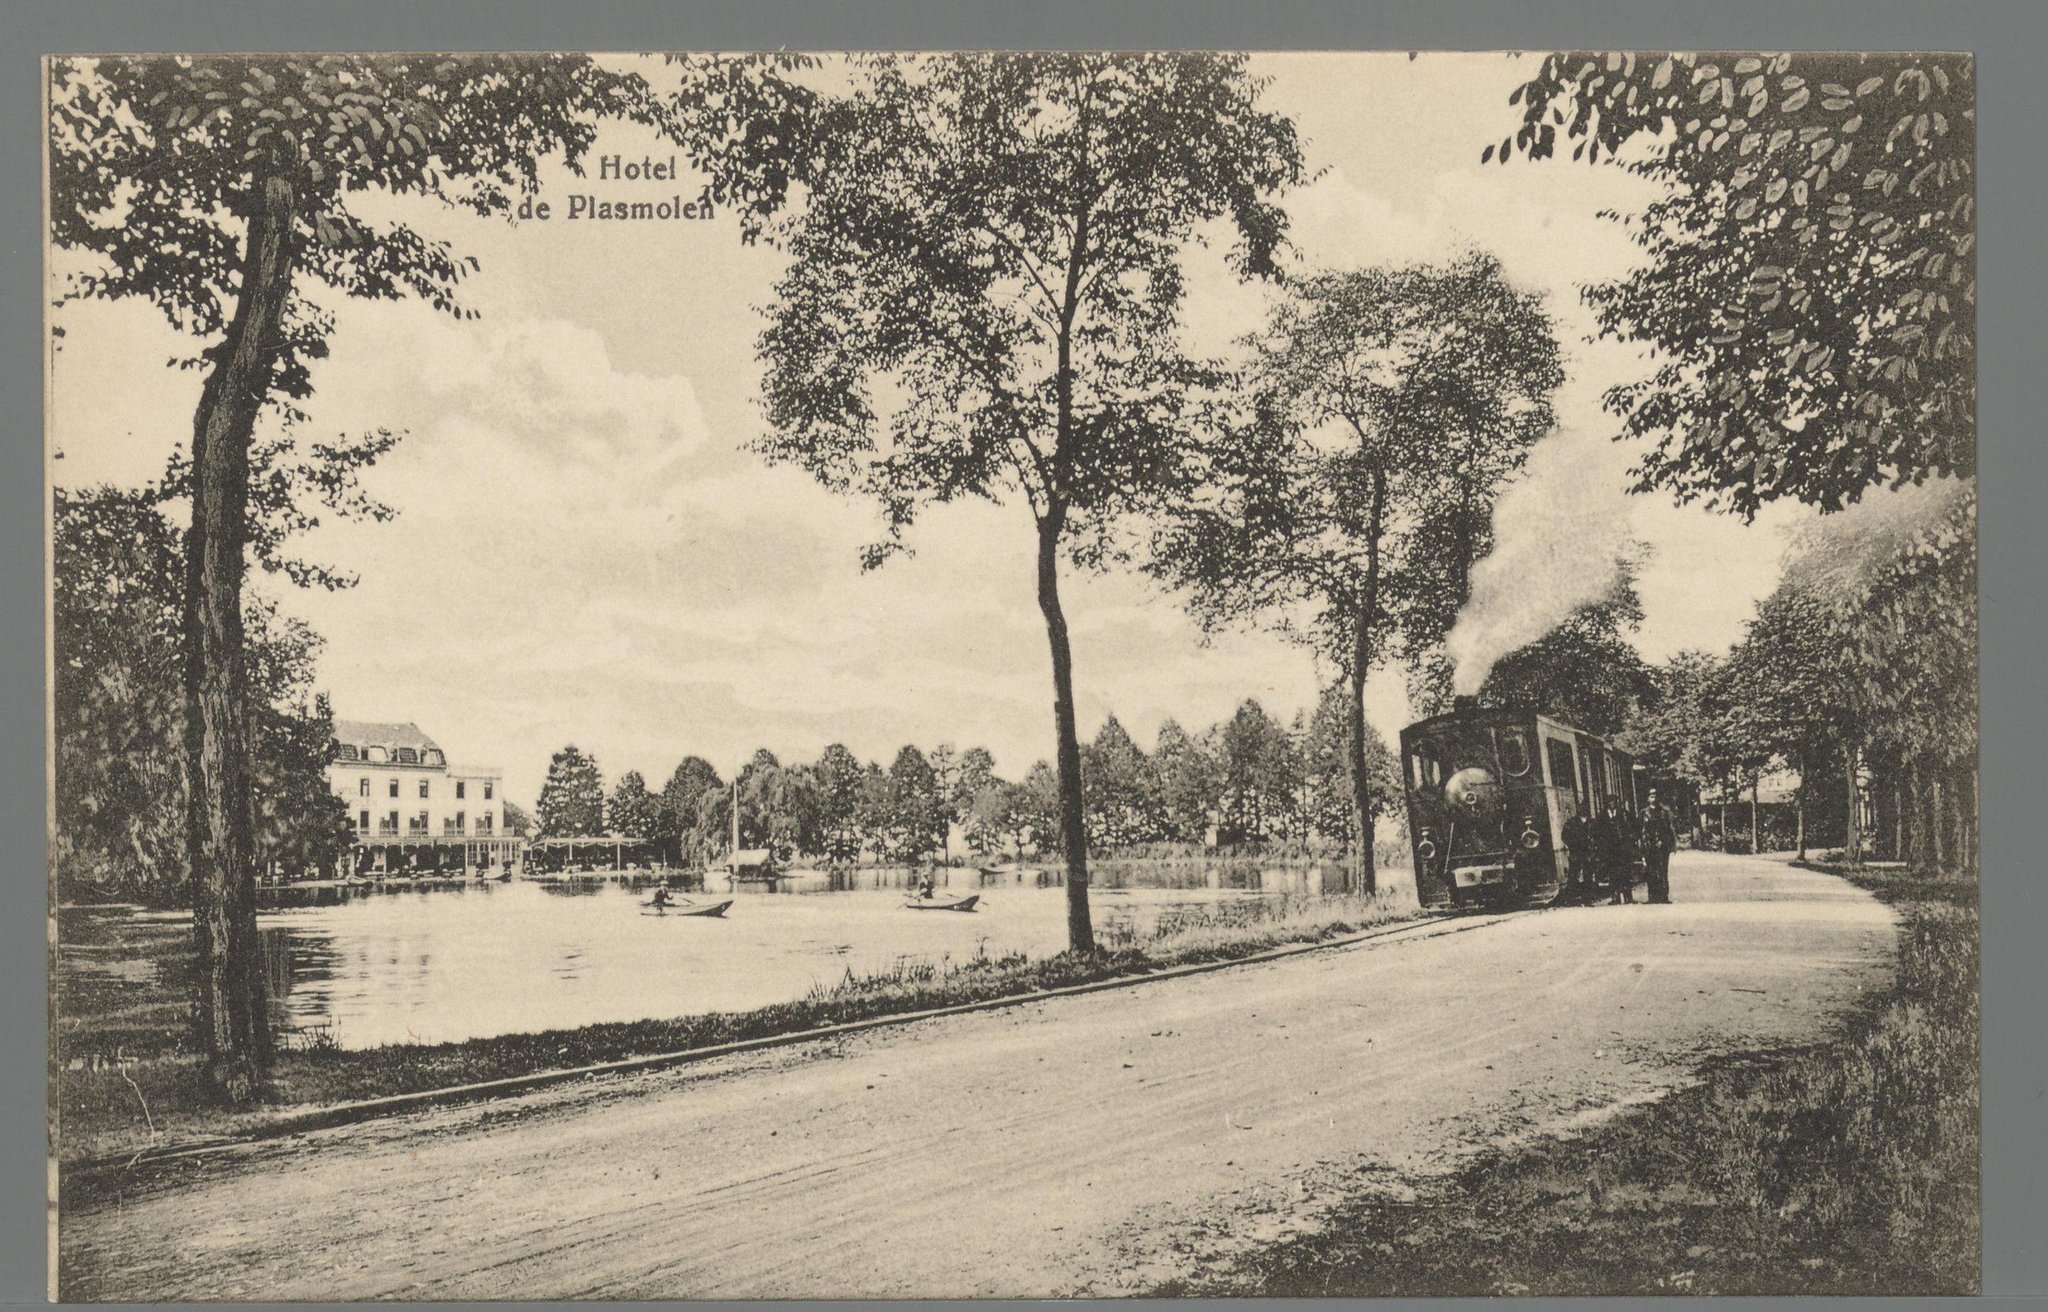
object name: photomechanical print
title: Hotel de Plasmolen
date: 1910-1929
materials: cardboard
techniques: photograph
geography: plasmolen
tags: pond, hotel, hostelry, inn, steam locomotive